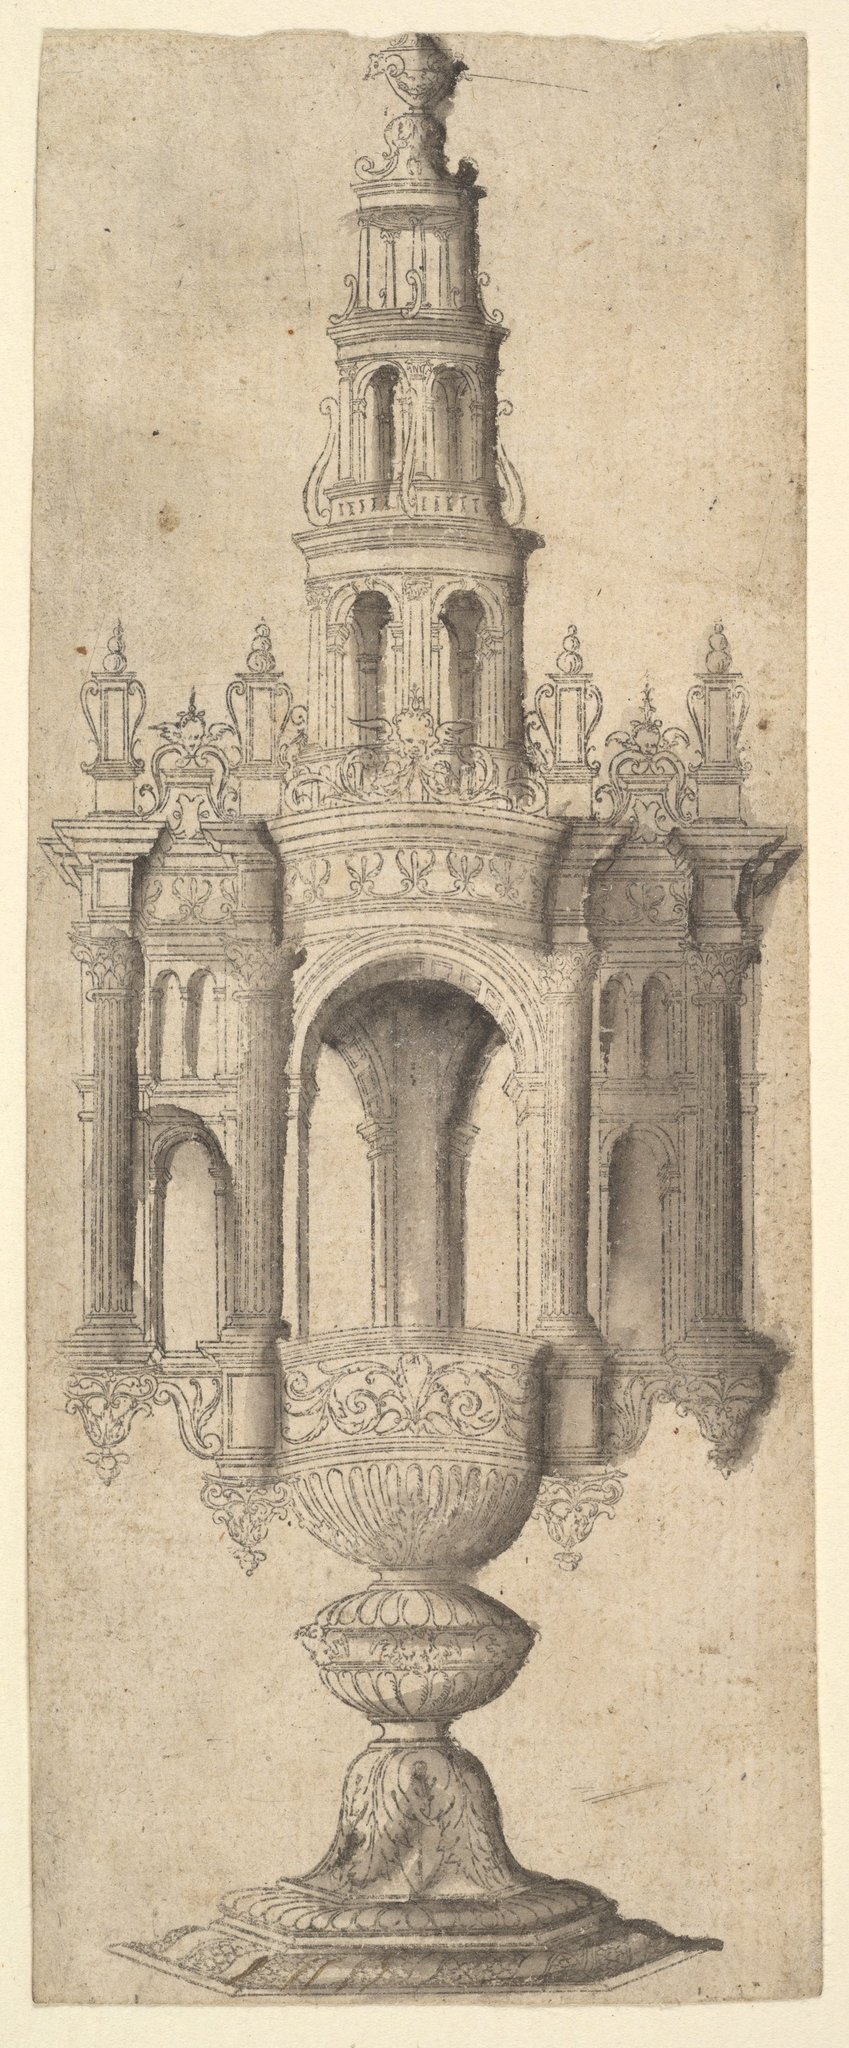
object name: print ornament architecture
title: An Architectural Monstrance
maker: anonymous, french, 16th century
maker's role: artist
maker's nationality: french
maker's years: 1500-1600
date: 1530-1540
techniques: etching, wash